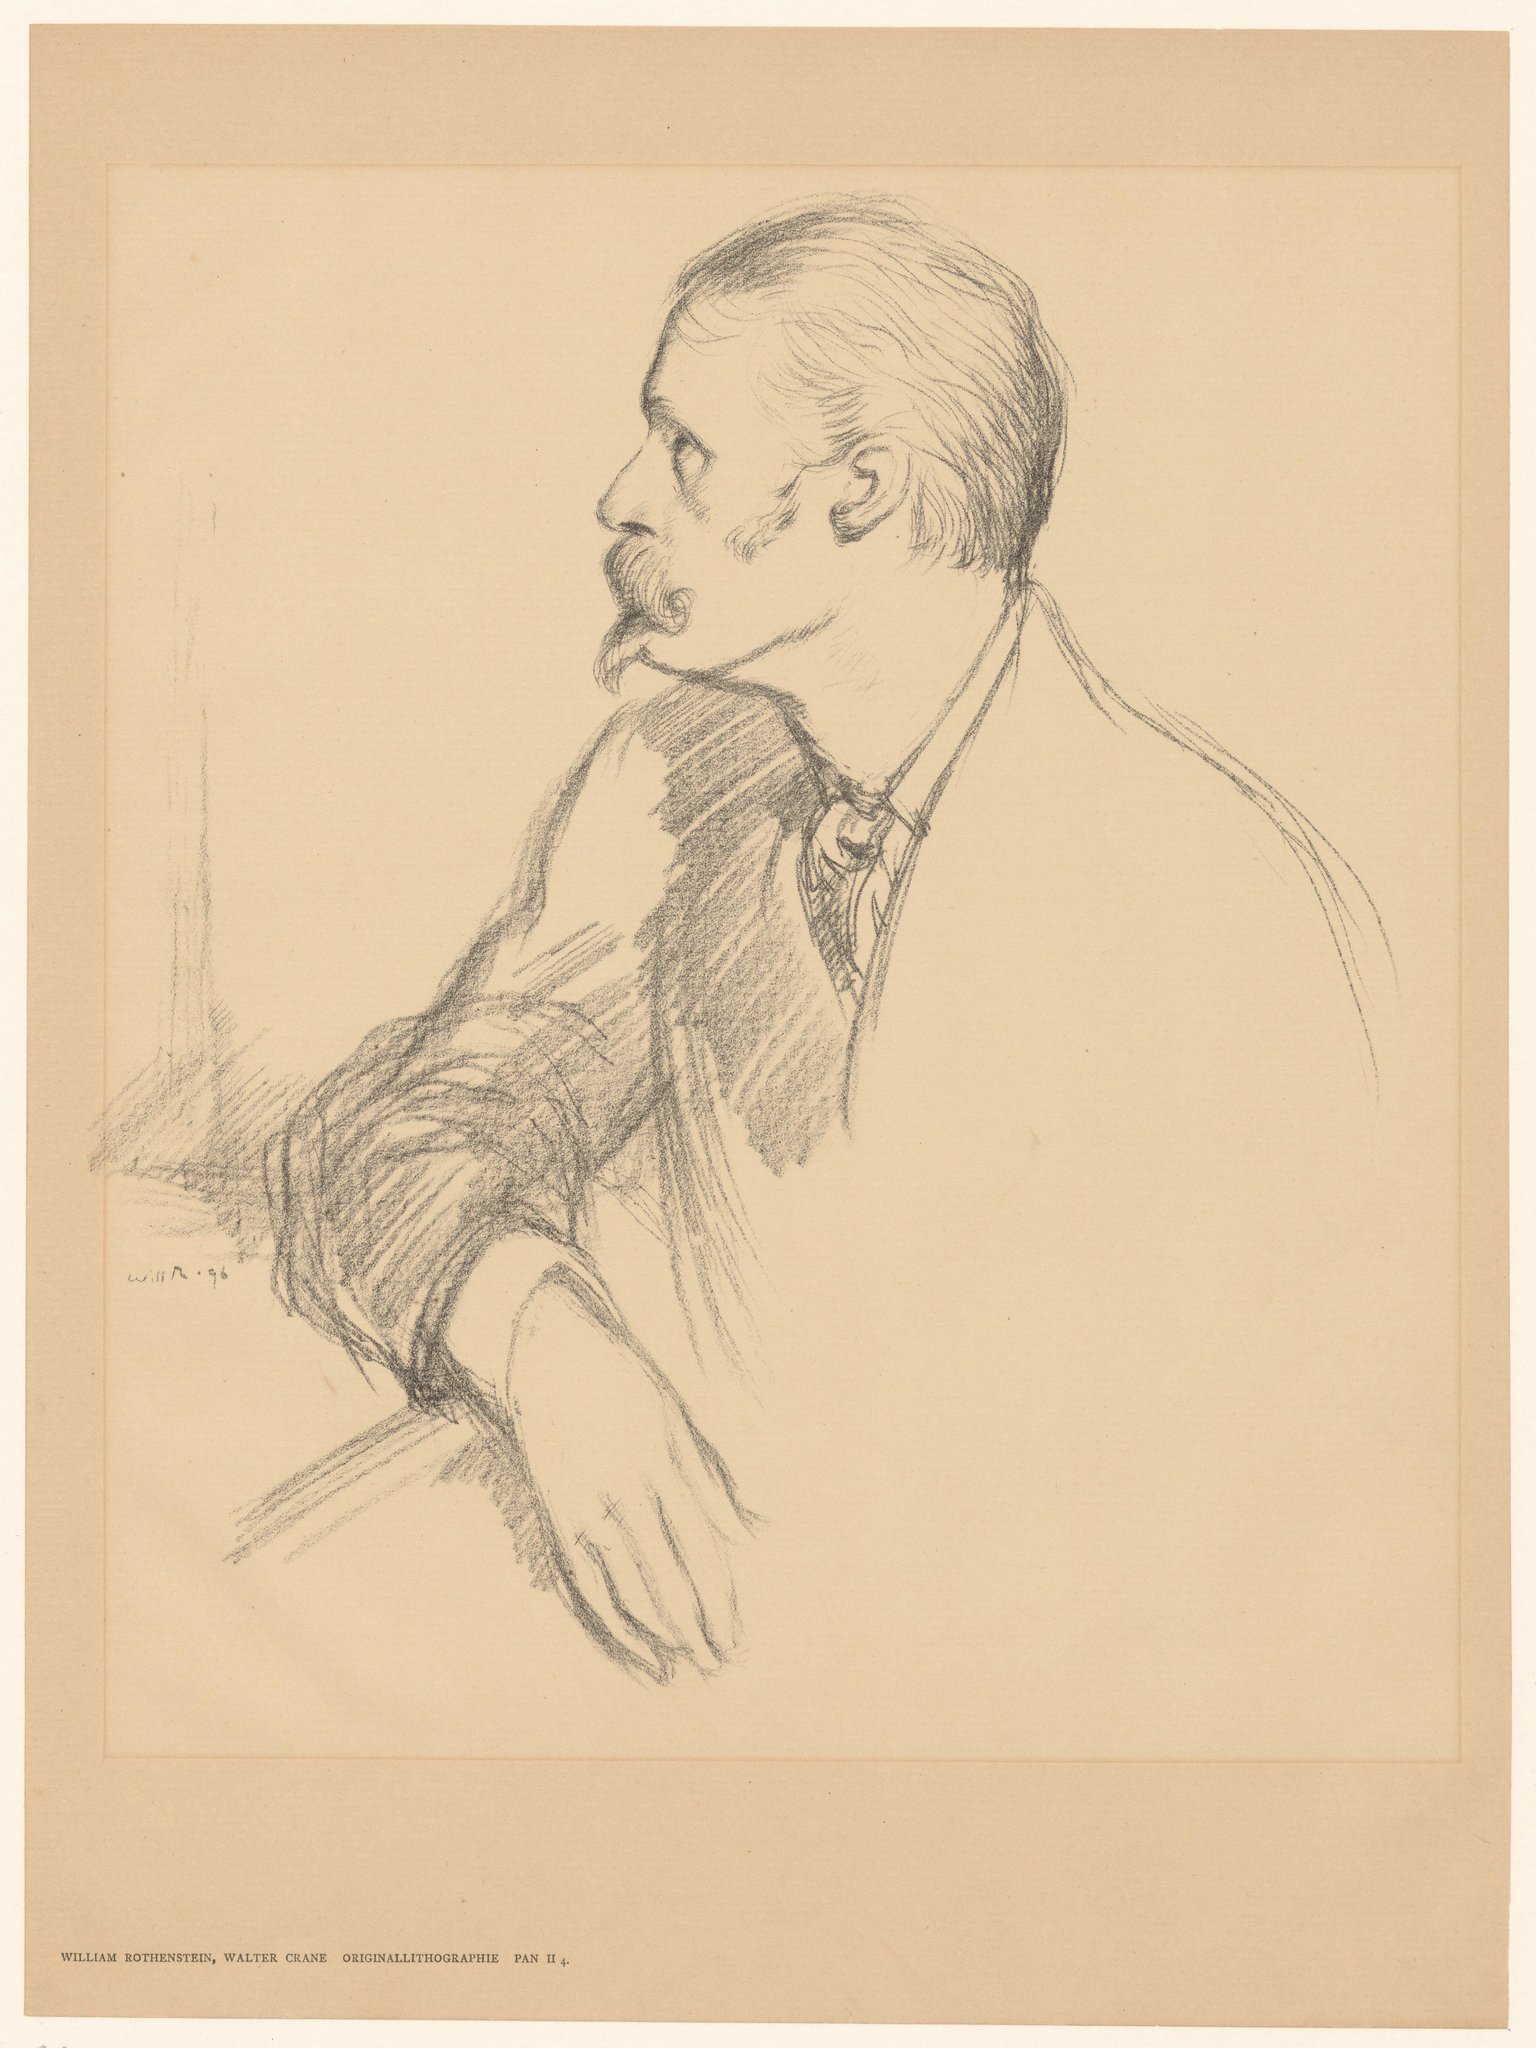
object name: print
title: Portret van Walter Crane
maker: william rothenstein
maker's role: print maker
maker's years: 1872-1945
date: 1896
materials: paper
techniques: lithograph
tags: liverpool, london, print maker, draughtsman, walter crane, adult man, historical persons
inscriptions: collector's mark: Lugt 2228